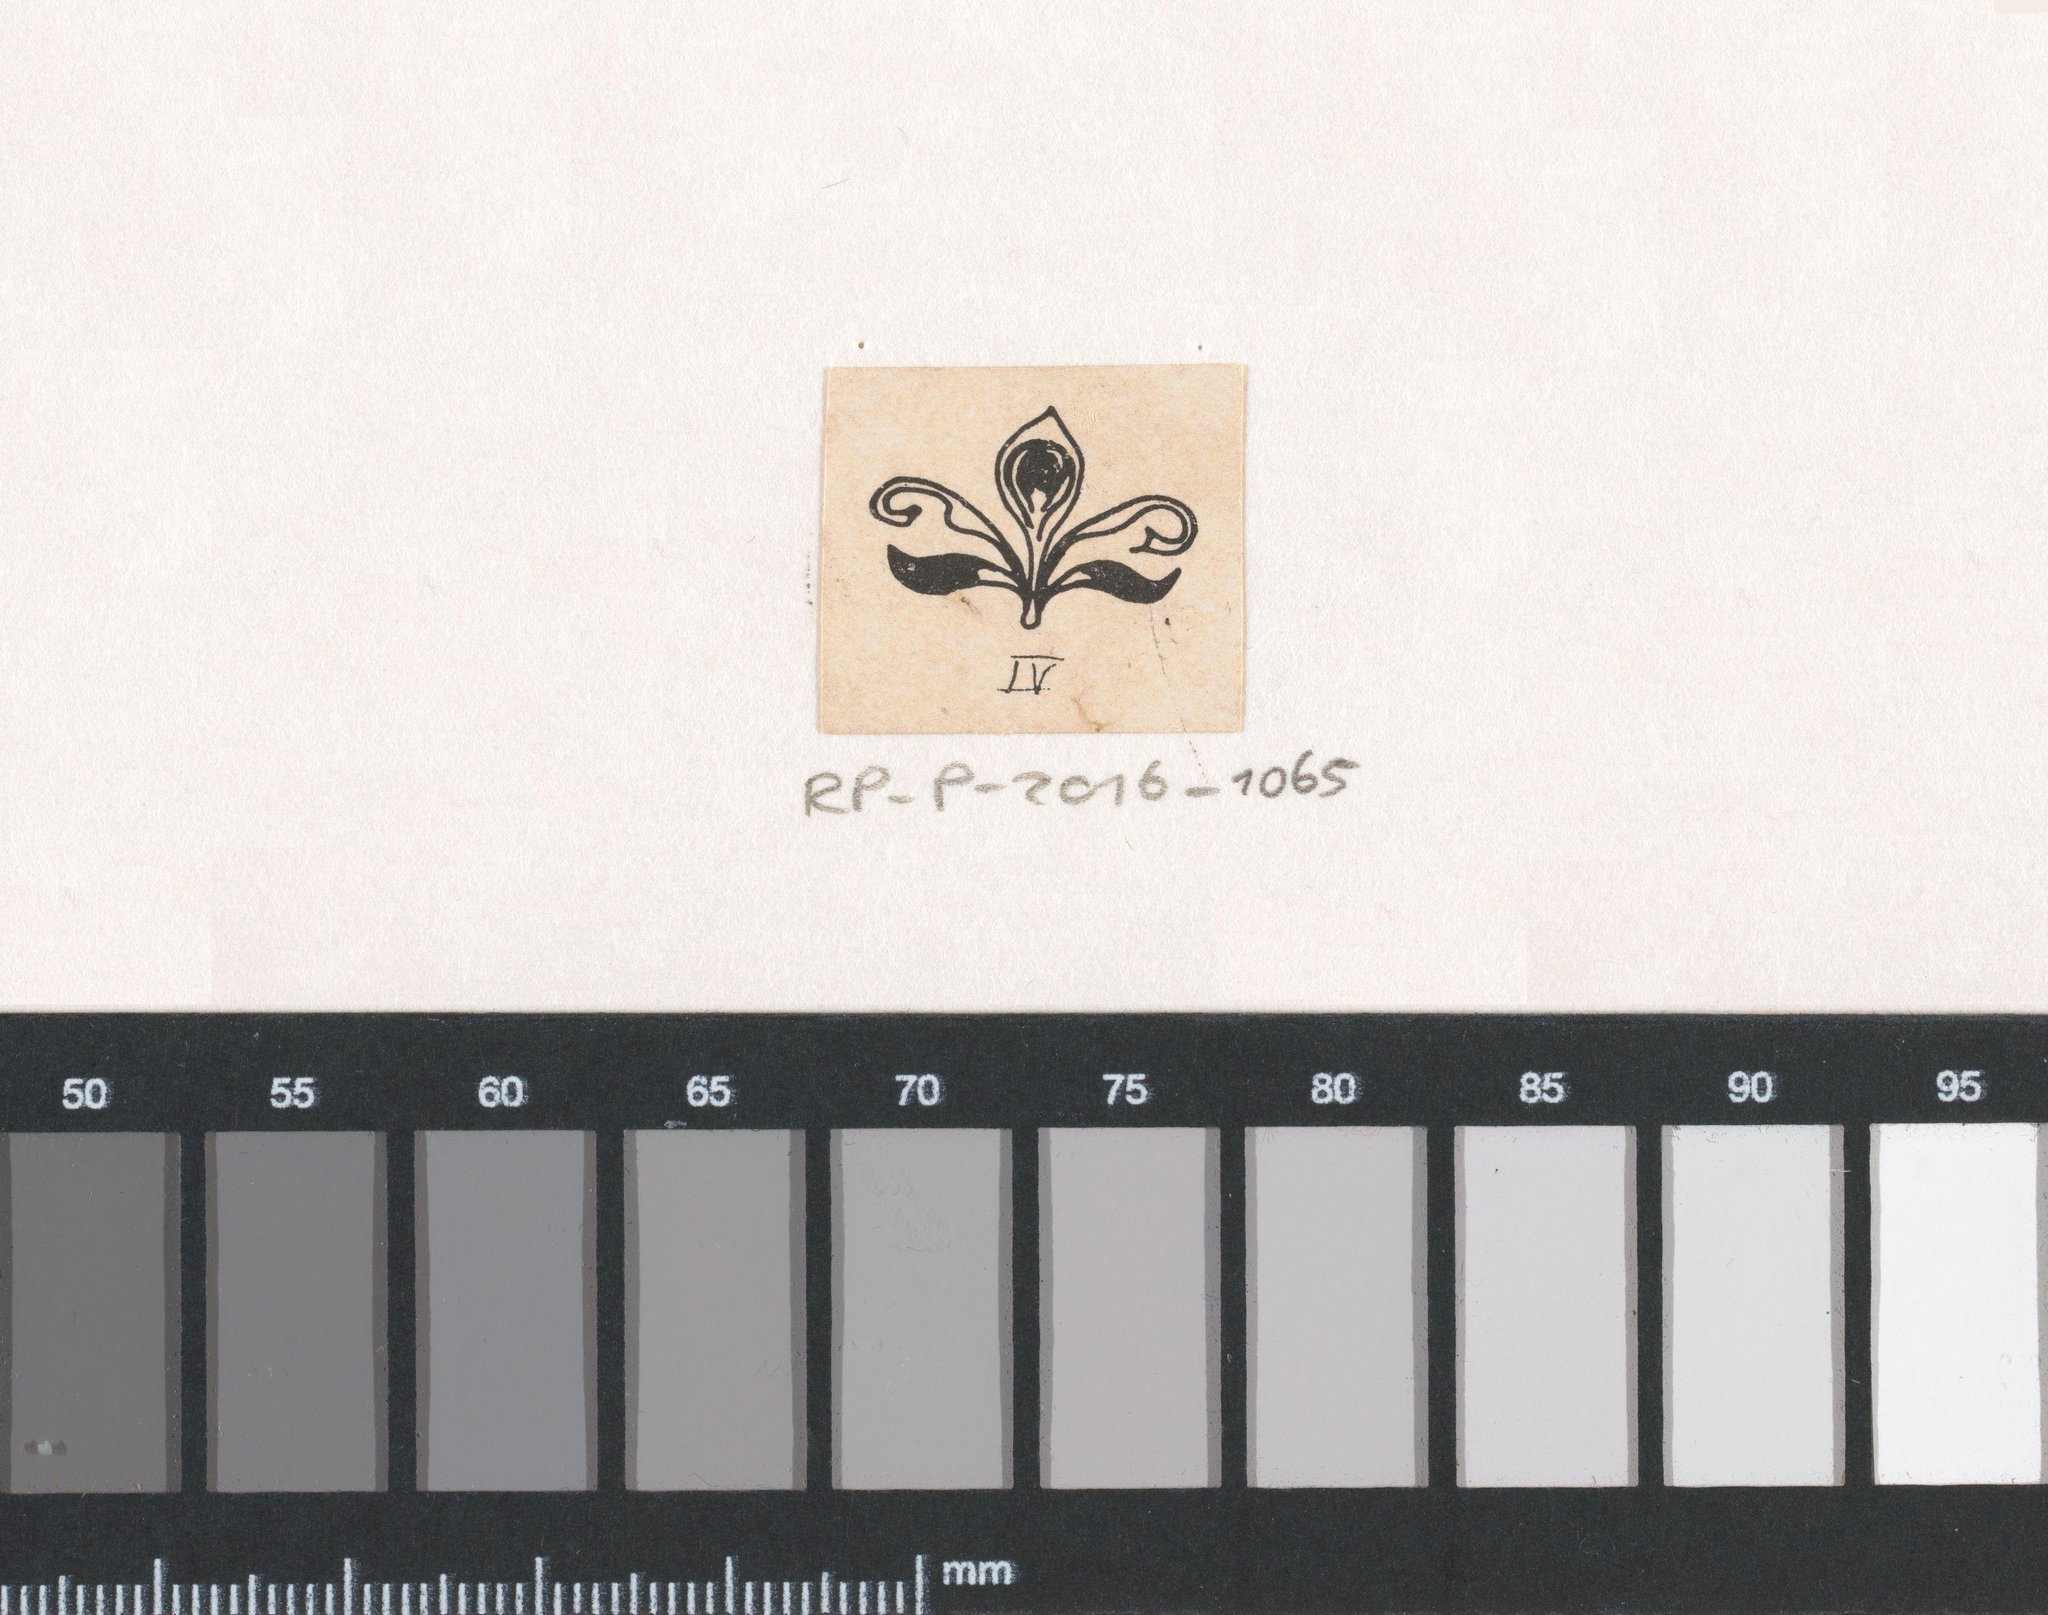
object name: photomechanical print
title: Ornament met bloem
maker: Anonymous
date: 1870-1937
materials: paper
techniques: printing block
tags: flowers ~ ornament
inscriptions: number: ‘IV’